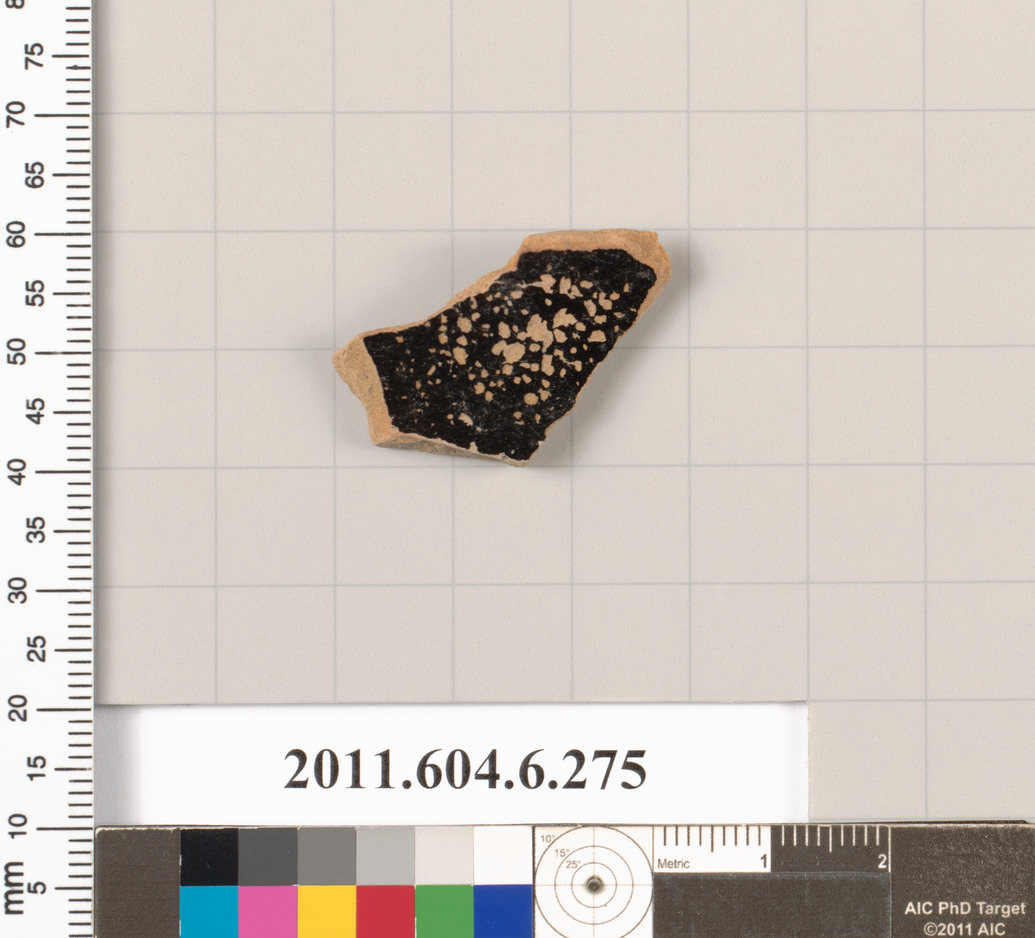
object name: undetermined shape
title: Terracotta fragment of an undetermined shape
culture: greek, attic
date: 600-401 BCE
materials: terracotta